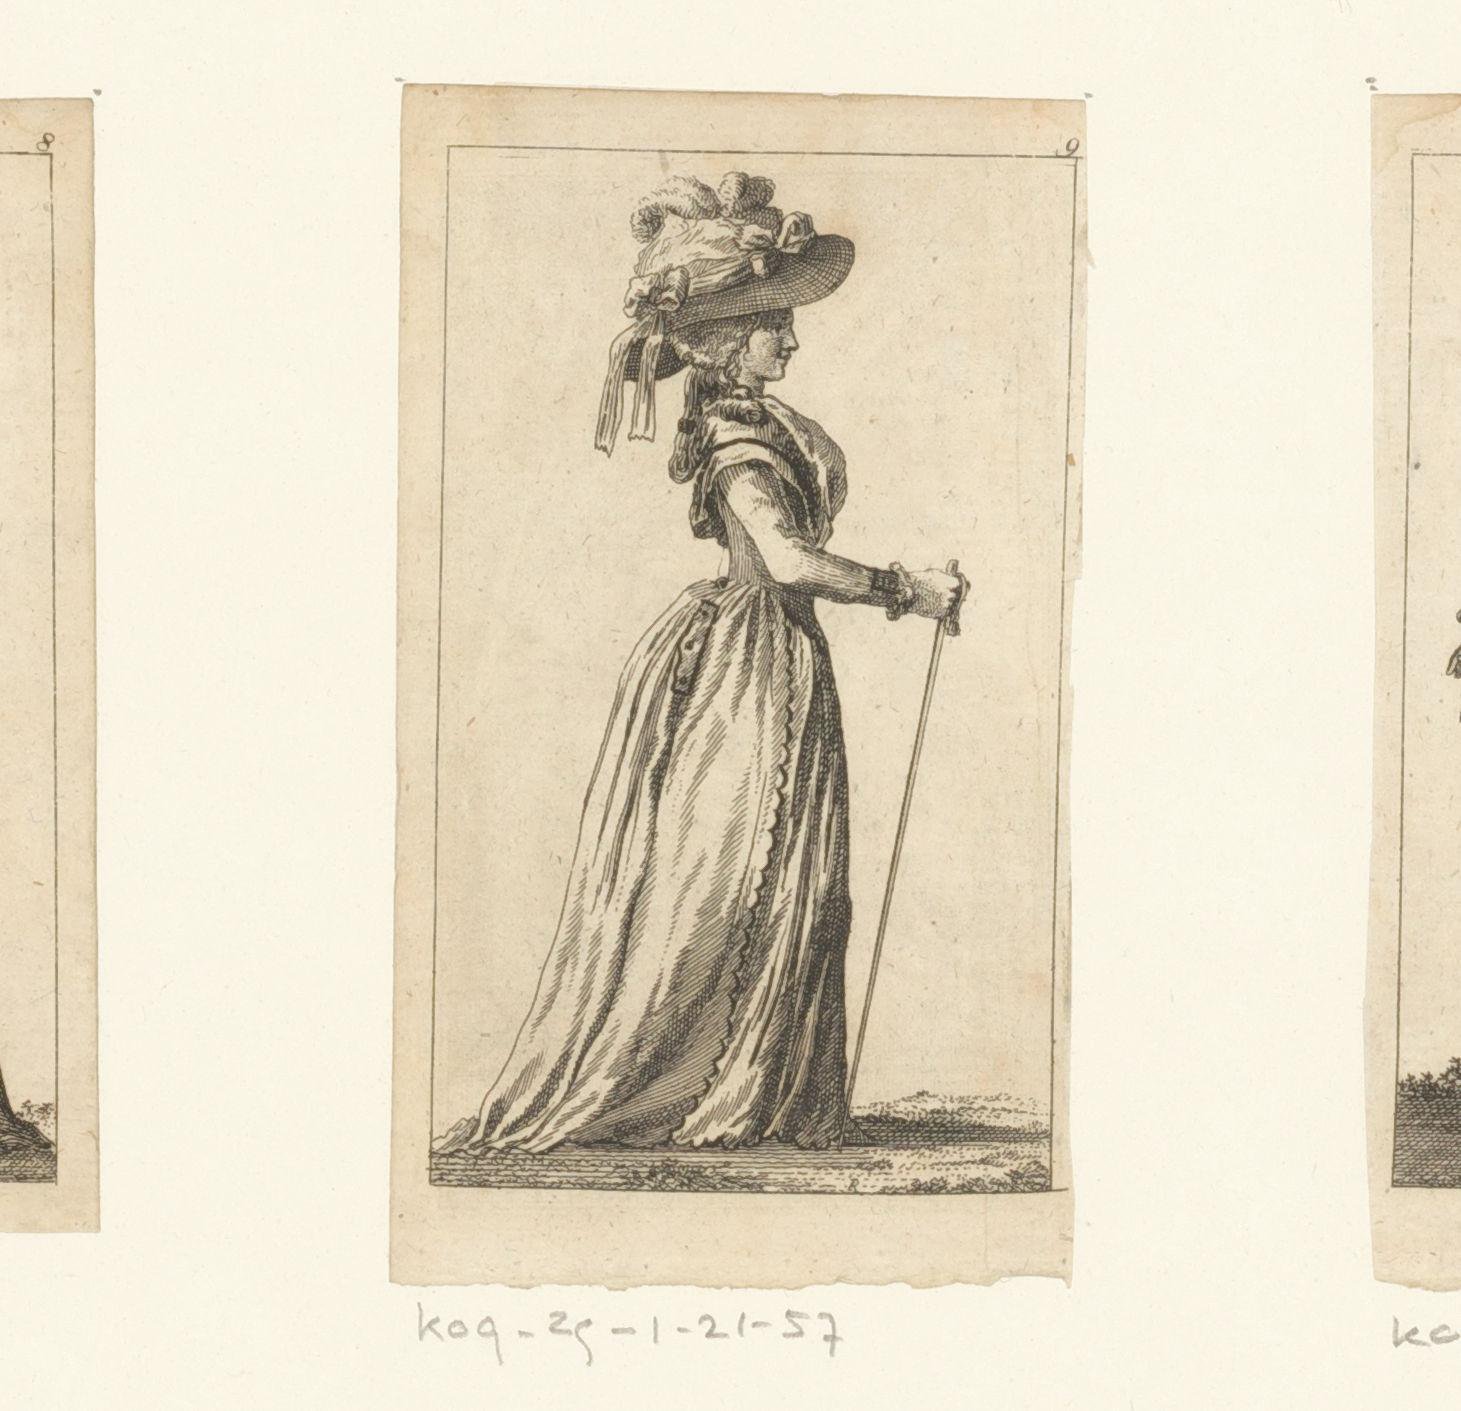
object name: print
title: Staande dame met hoed en een wandelstok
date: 1780-1840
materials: paper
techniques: etching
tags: walking-stick, staff, head-gear: hat, standing figure - aa - female human figure, dress, gown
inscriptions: stamp, collector's mark: Lugt 1641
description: Rechtsboven genummerd: 9. Onderwerpsrubrieken binnen de Atlas Zeden en Gewoonten: Zeden en Gewoonten in Engeren Zin, De Kleeding, Kleederdrachten (tijdvakken), De 18de eeuw (de pruikentijd). Mannen en vrouwen.